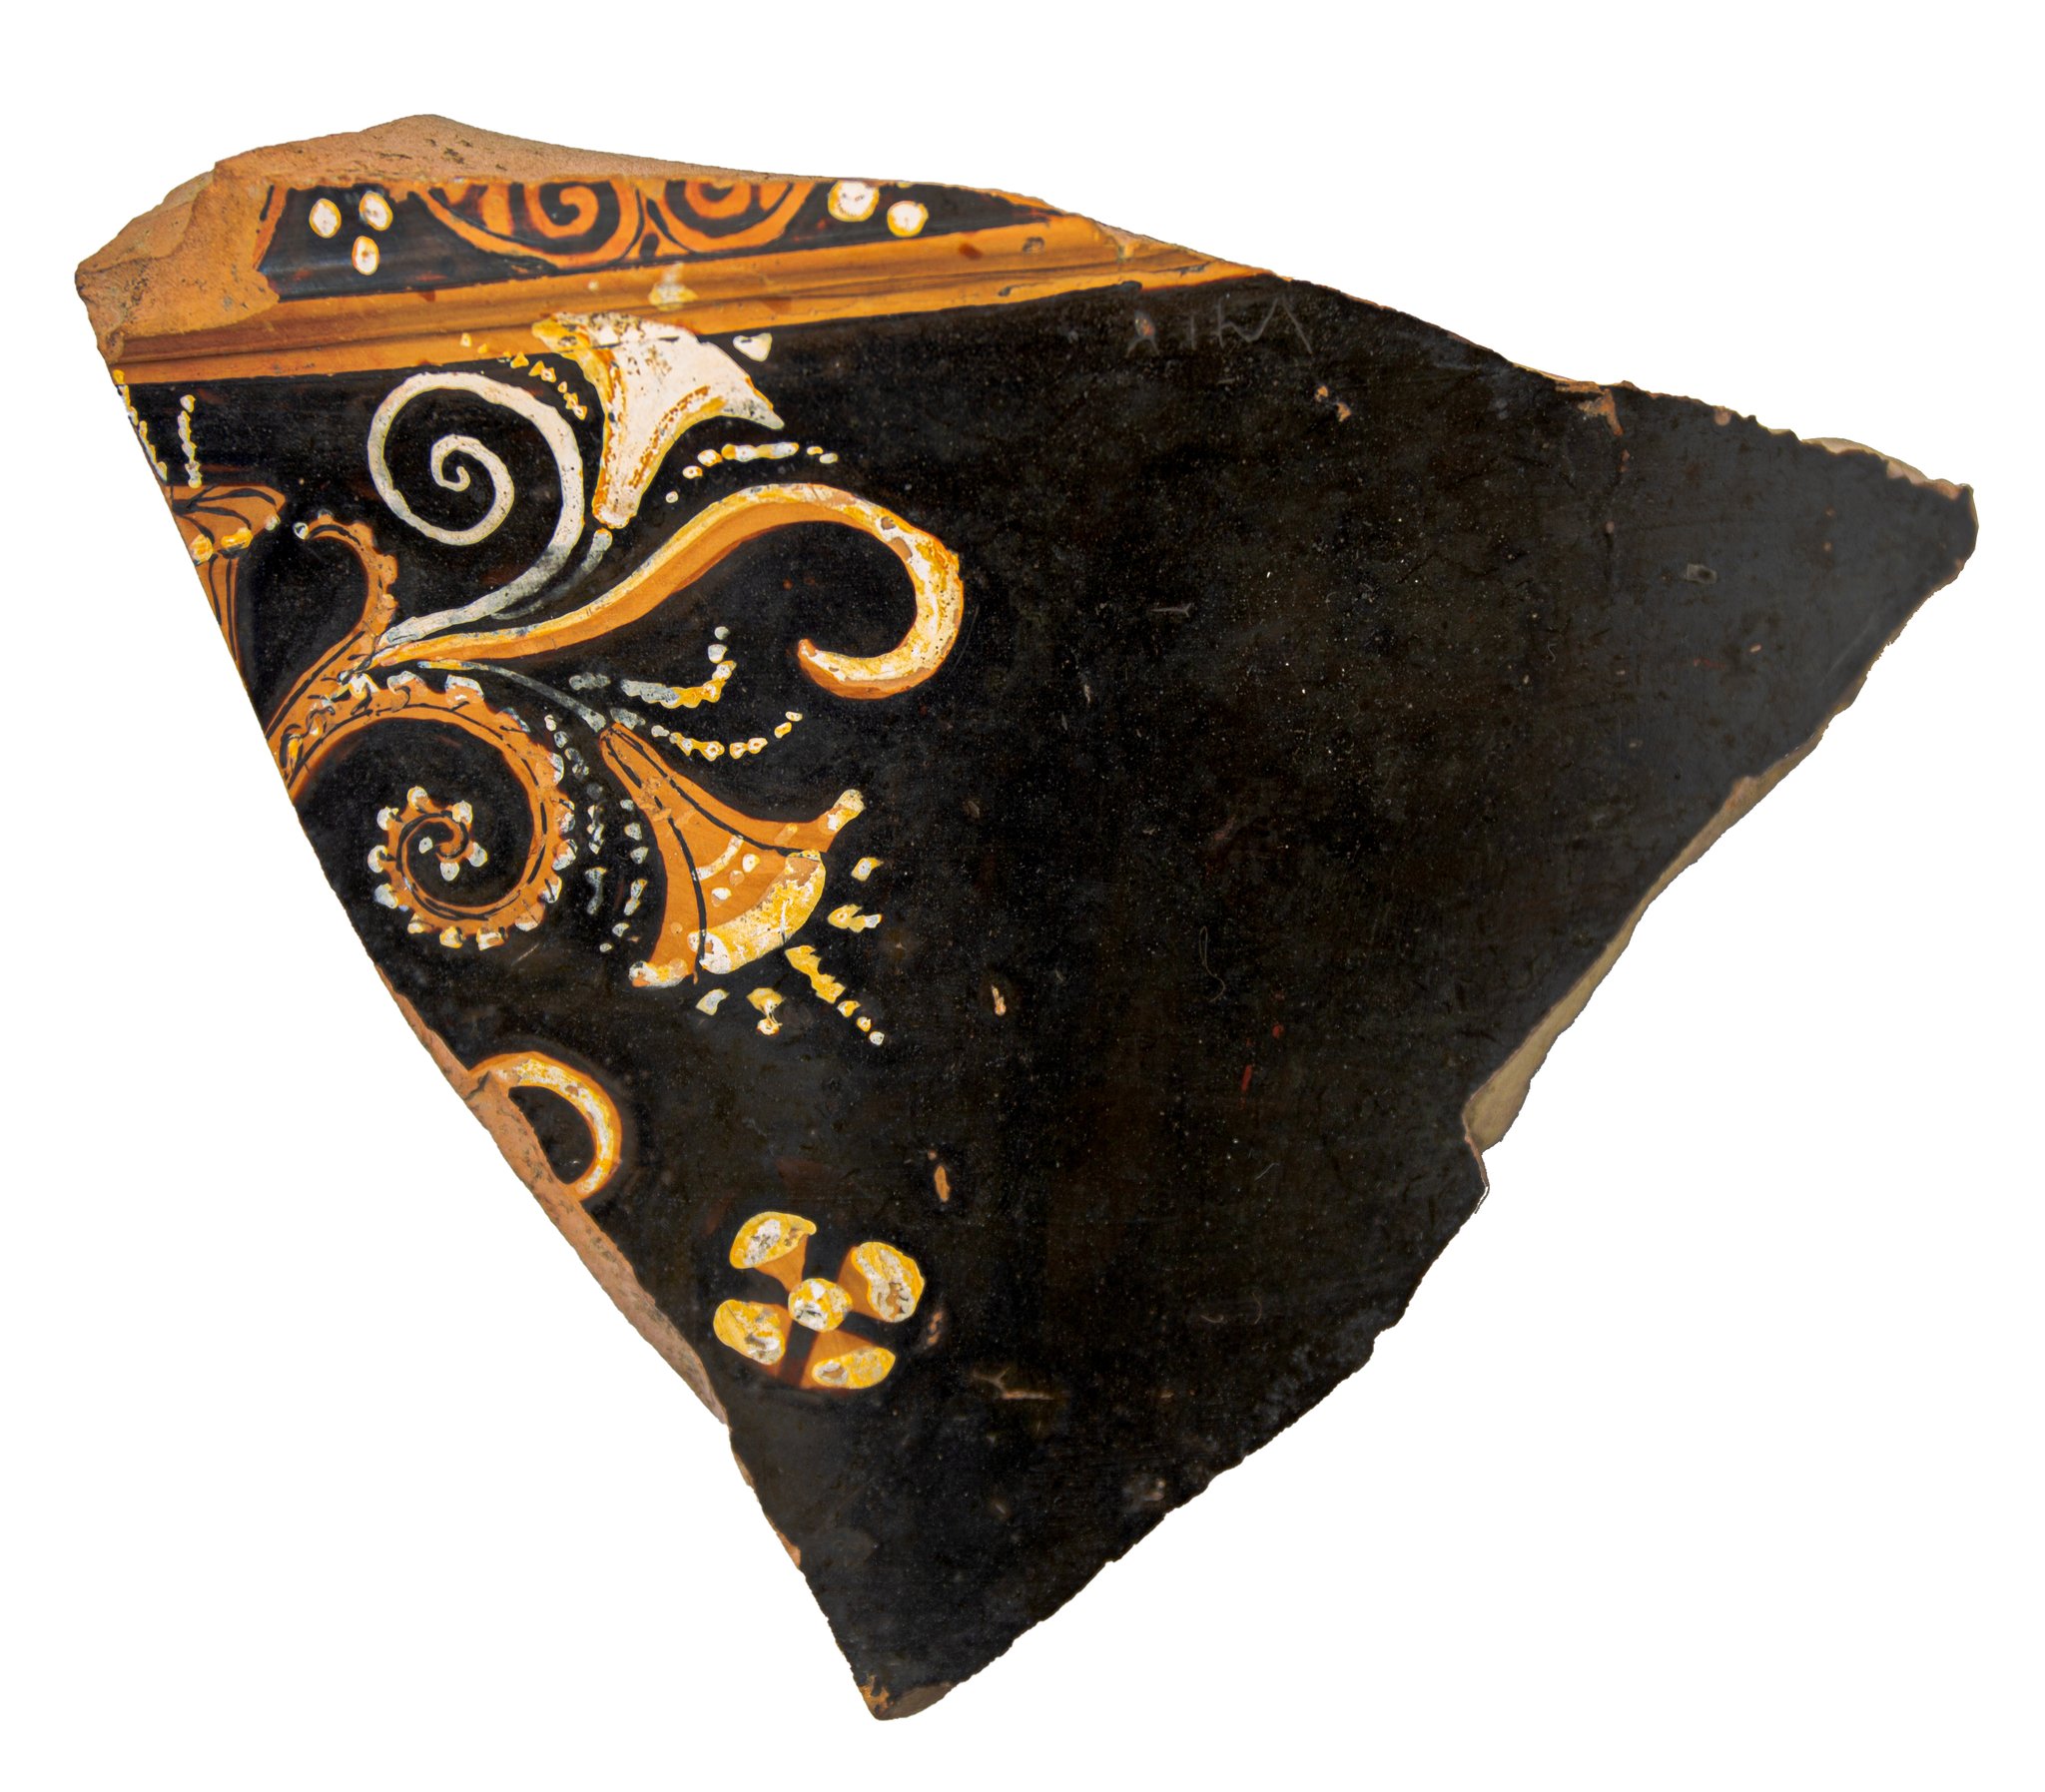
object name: volute krater fragment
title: Volute-krater fragment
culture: greek, south italian, apulian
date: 360-340 BCE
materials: terracotta